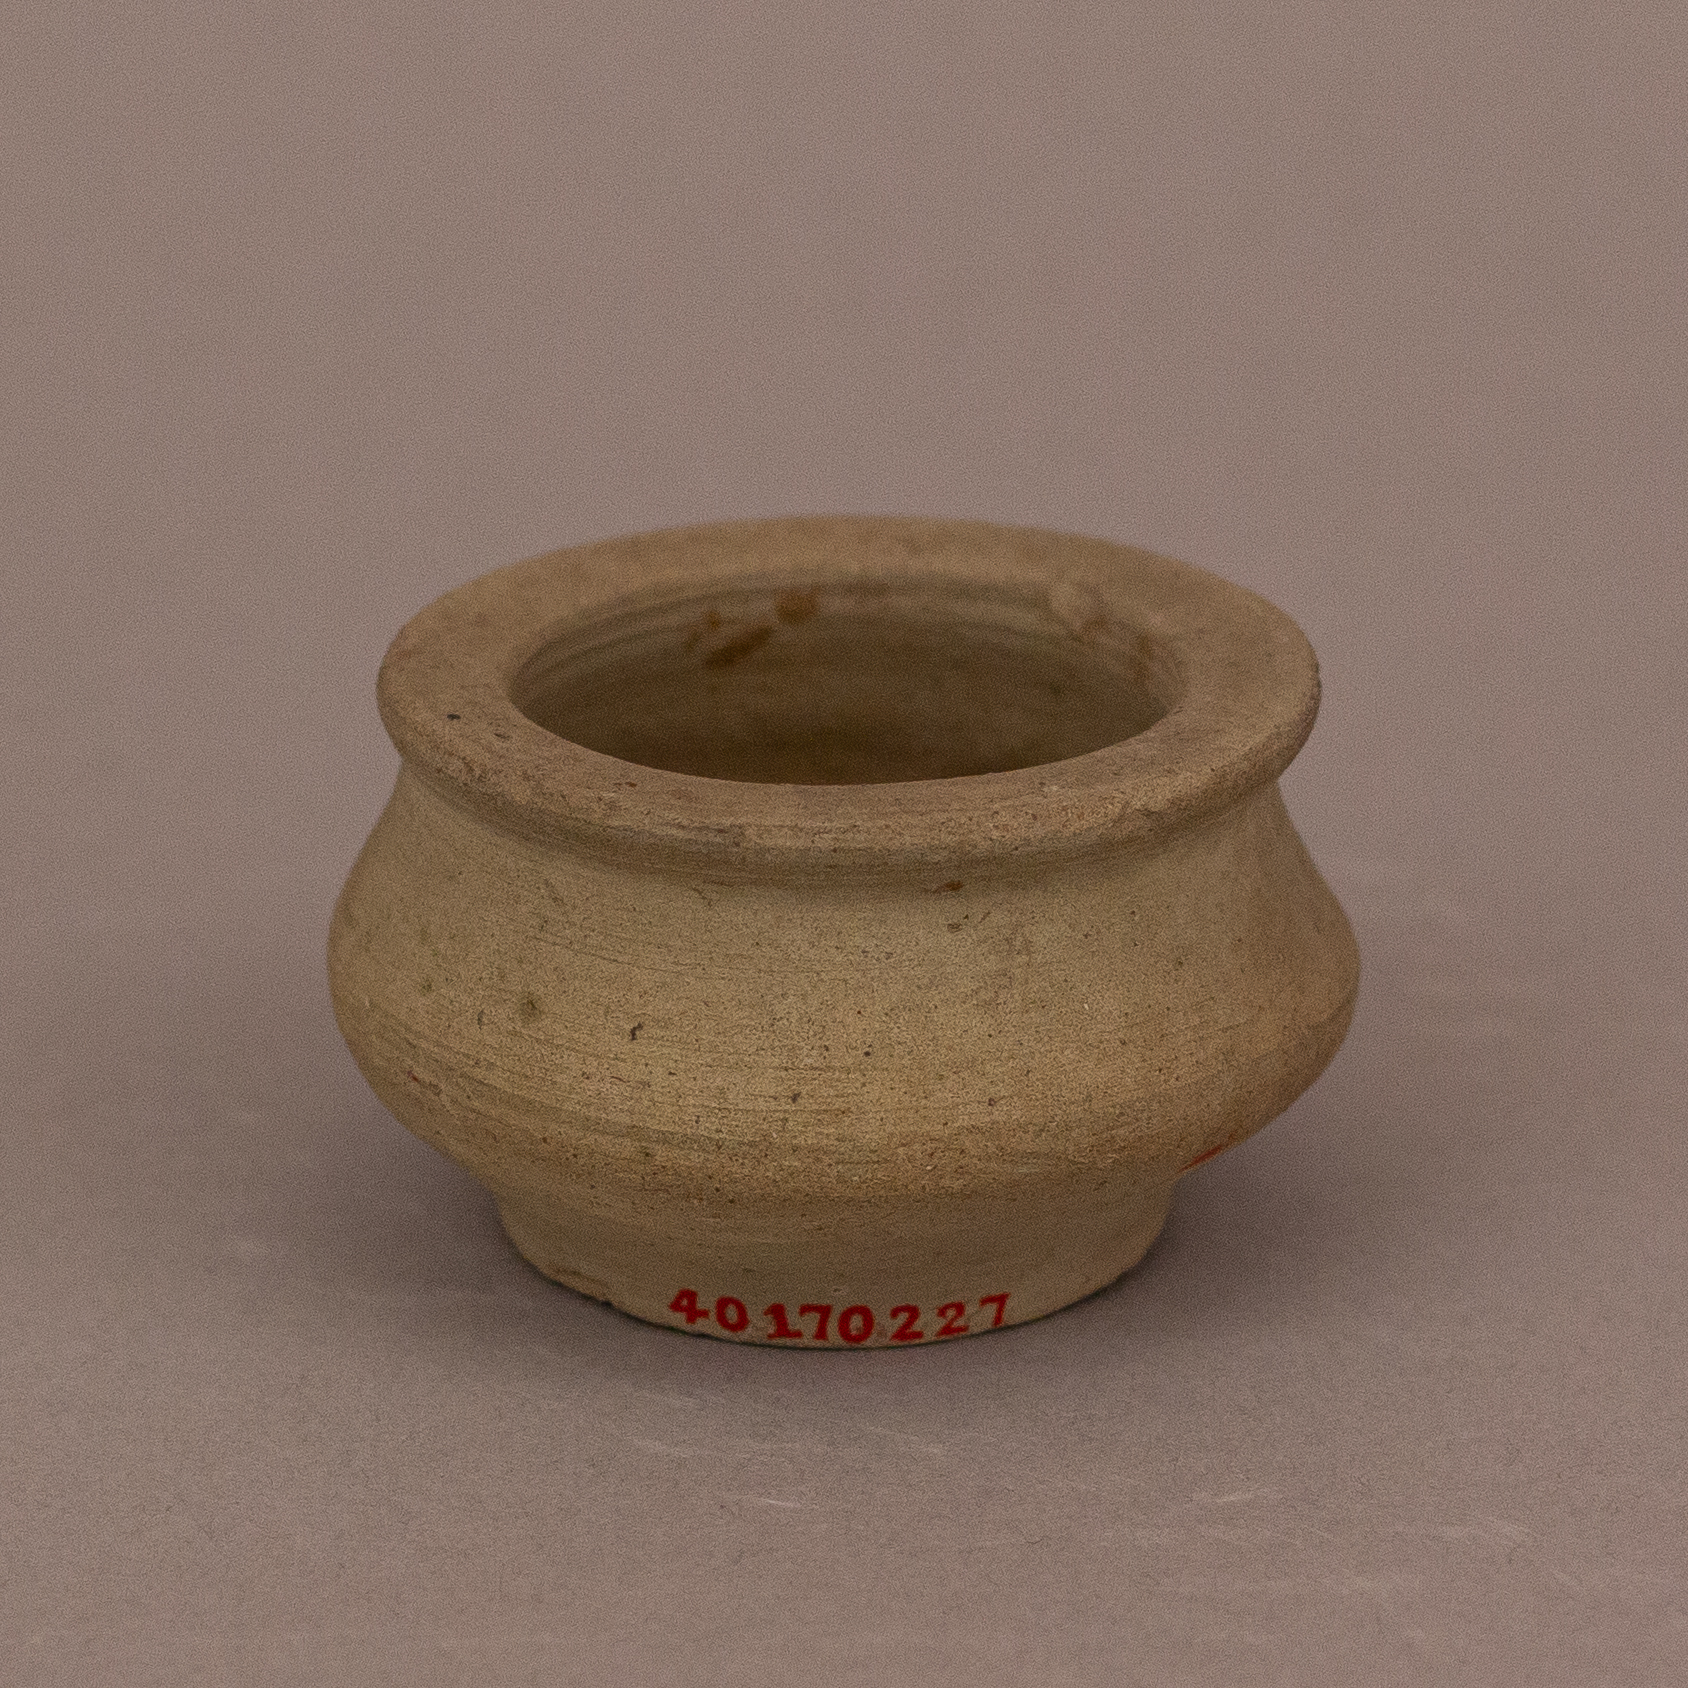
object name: bowl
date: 801-1000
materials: earthenware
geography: iran